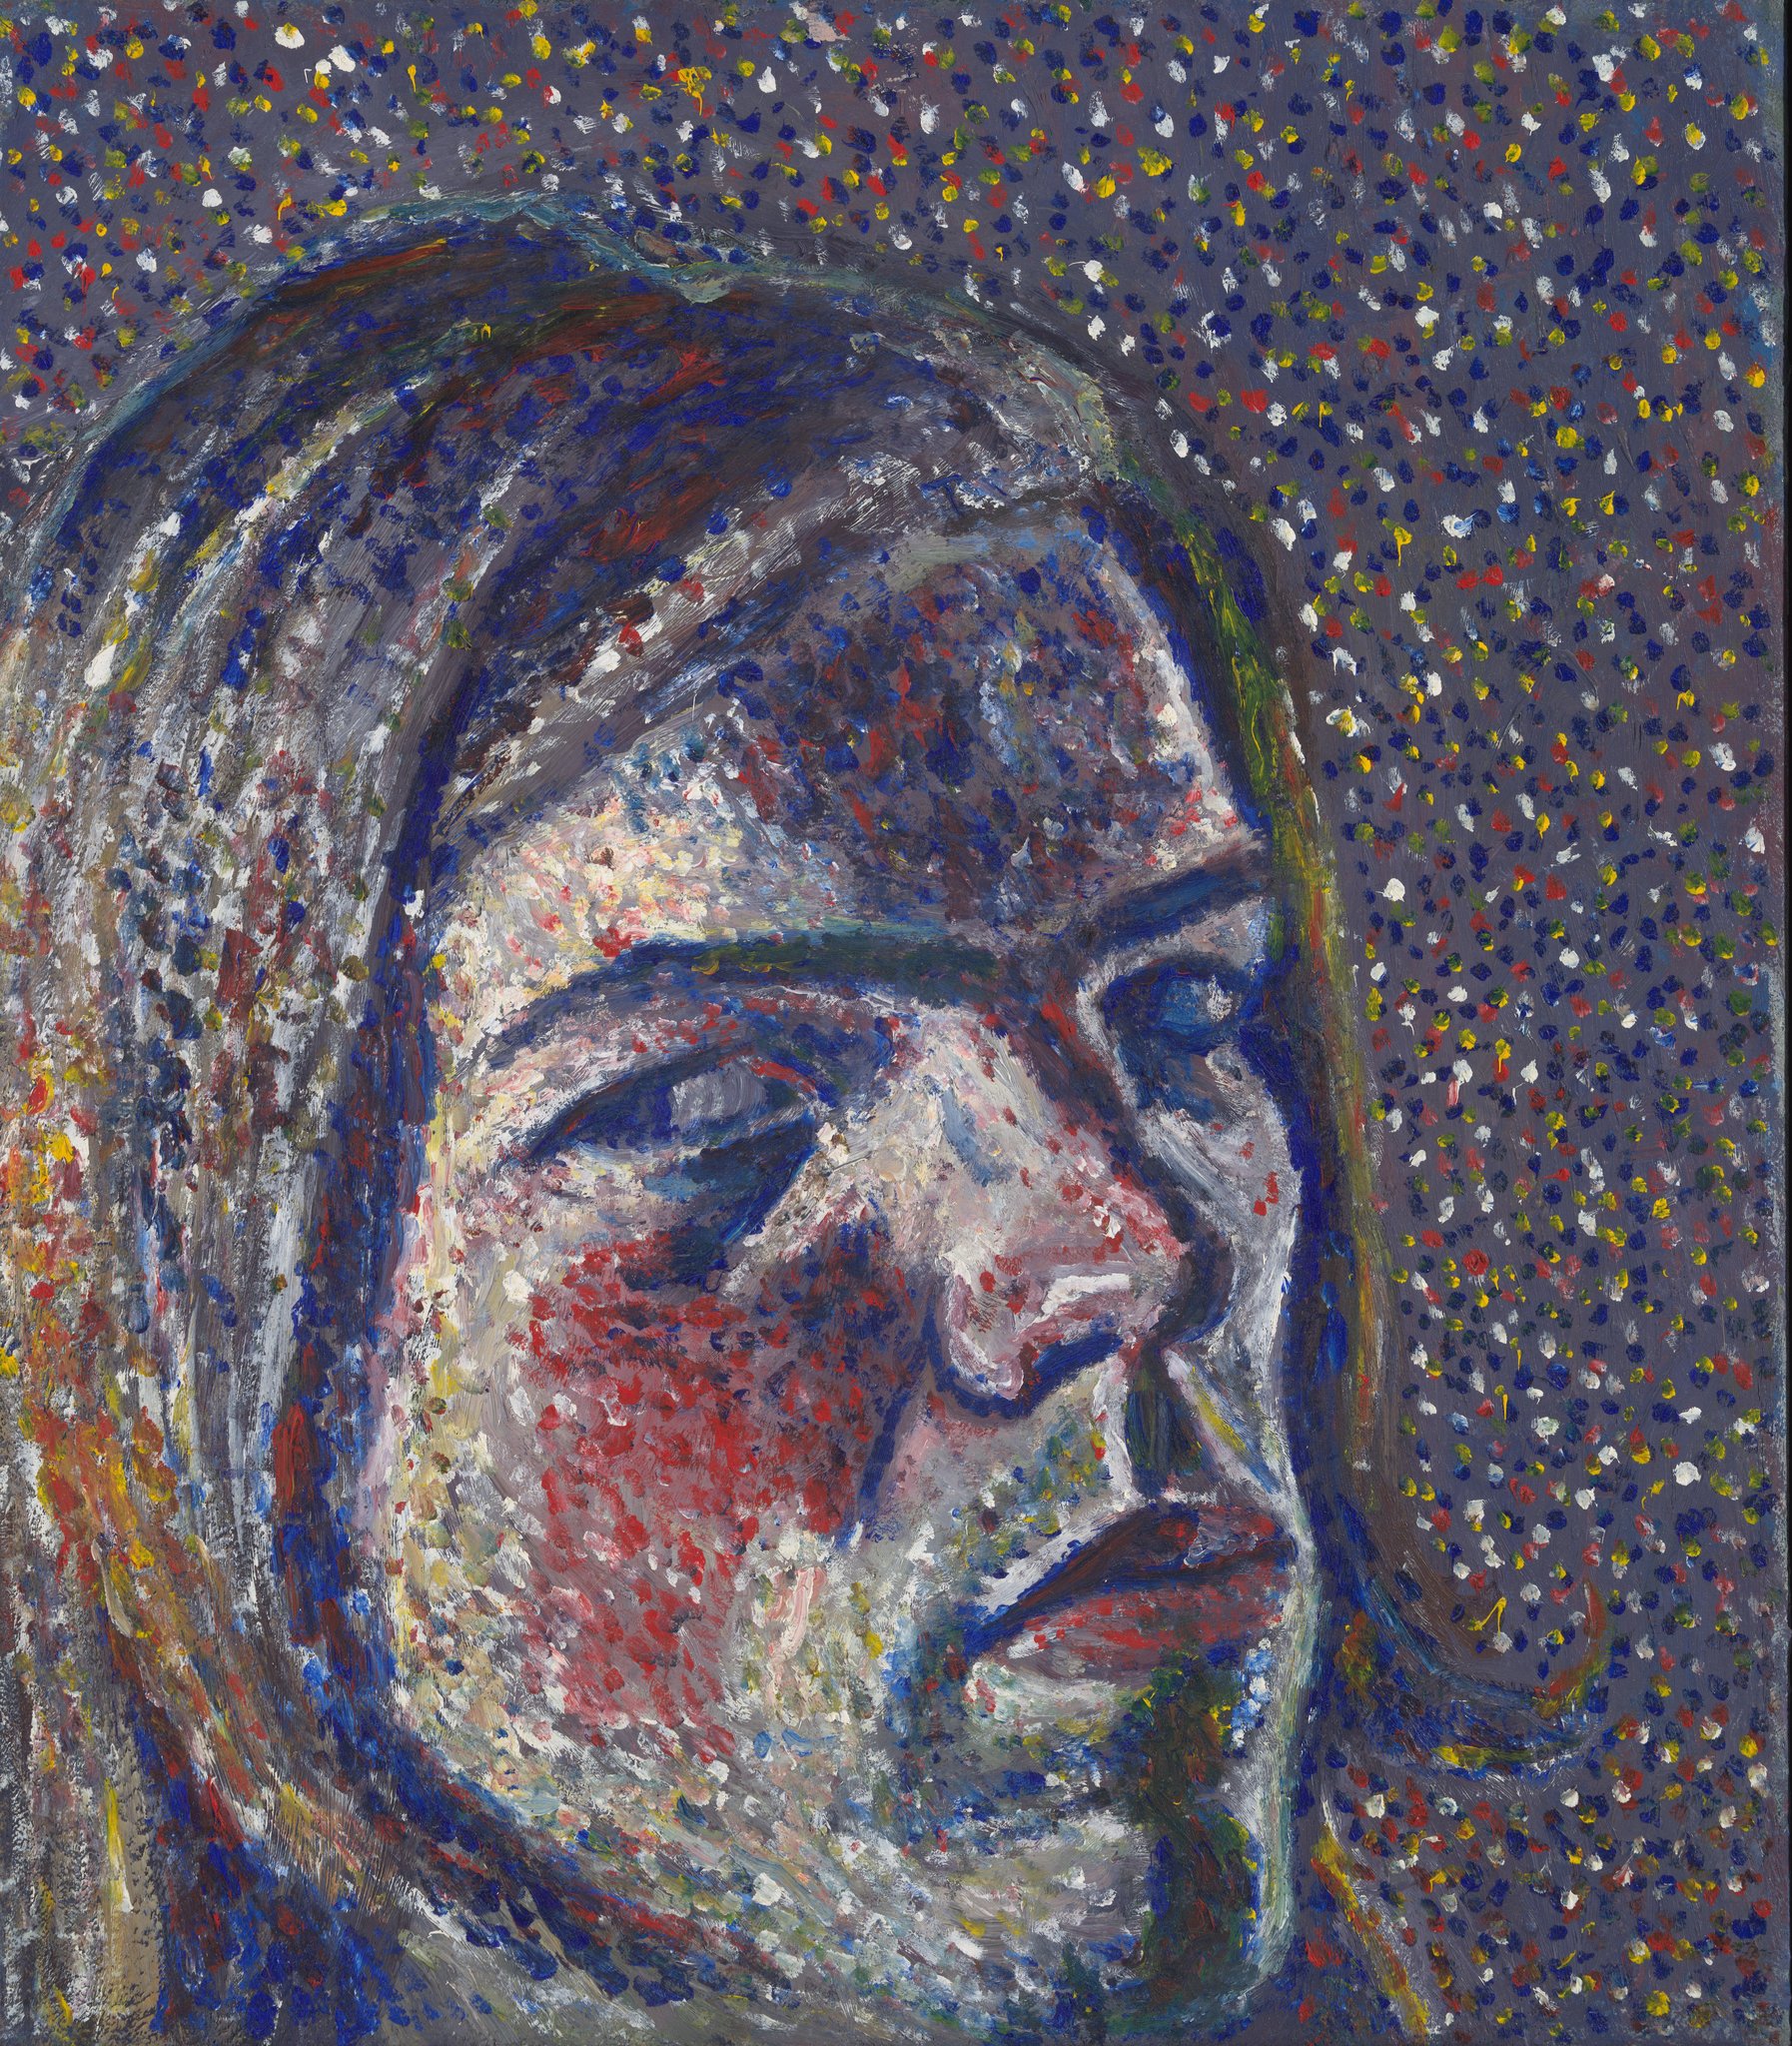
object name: frame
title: Grijs gebeitste en gelakte lijst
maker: Anonymous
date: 1982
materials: wood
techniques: lacquer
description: Gladde, grijs gebeitste en gelakte lijst. Aan de achterkant bevinden zich schroeven die in het spieraam van het schilderij.